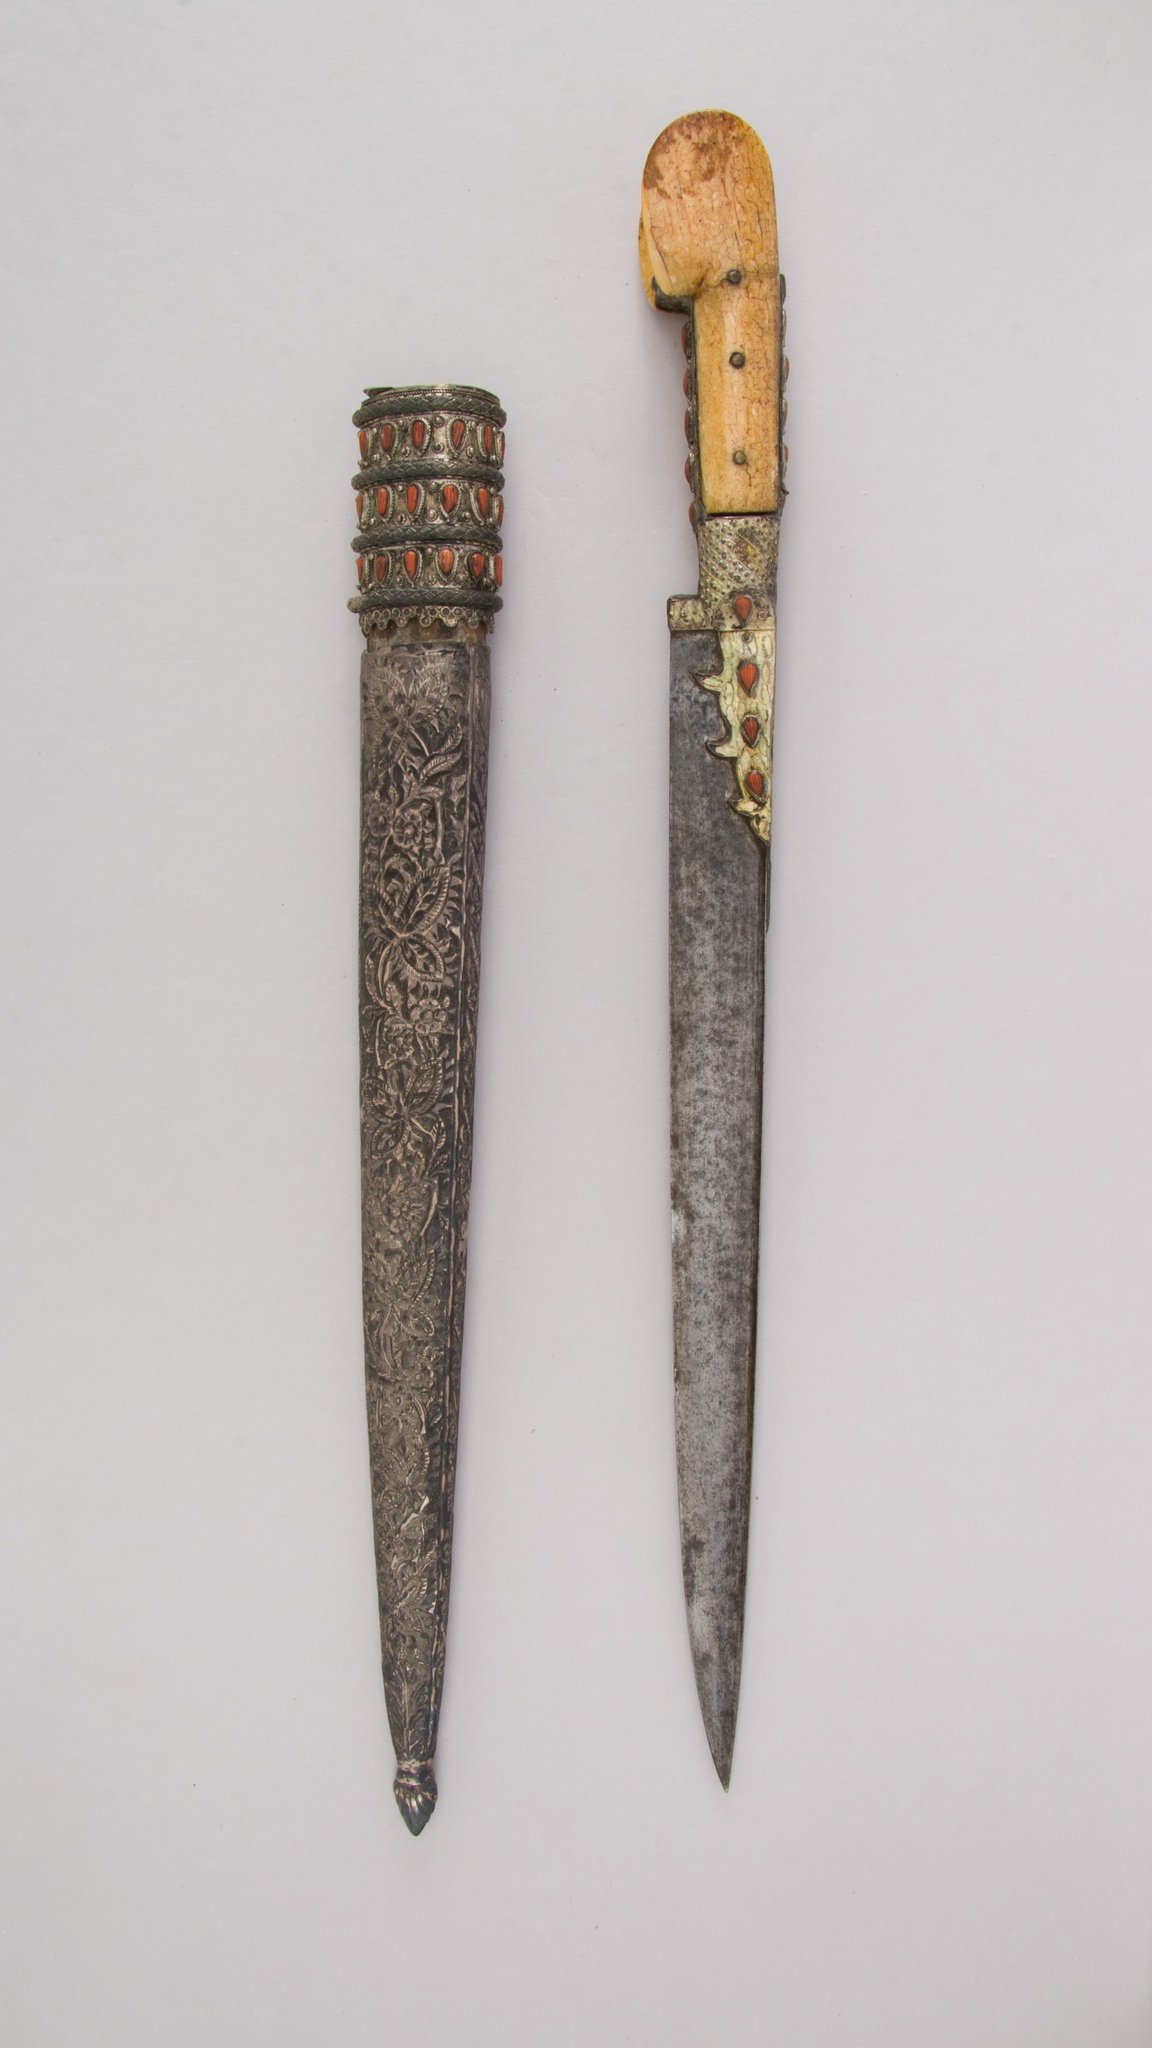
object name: dagger with sheath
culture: ottoman or turkish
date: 1801-1900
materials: coral, ivory, silver, steel, wood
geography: turkey